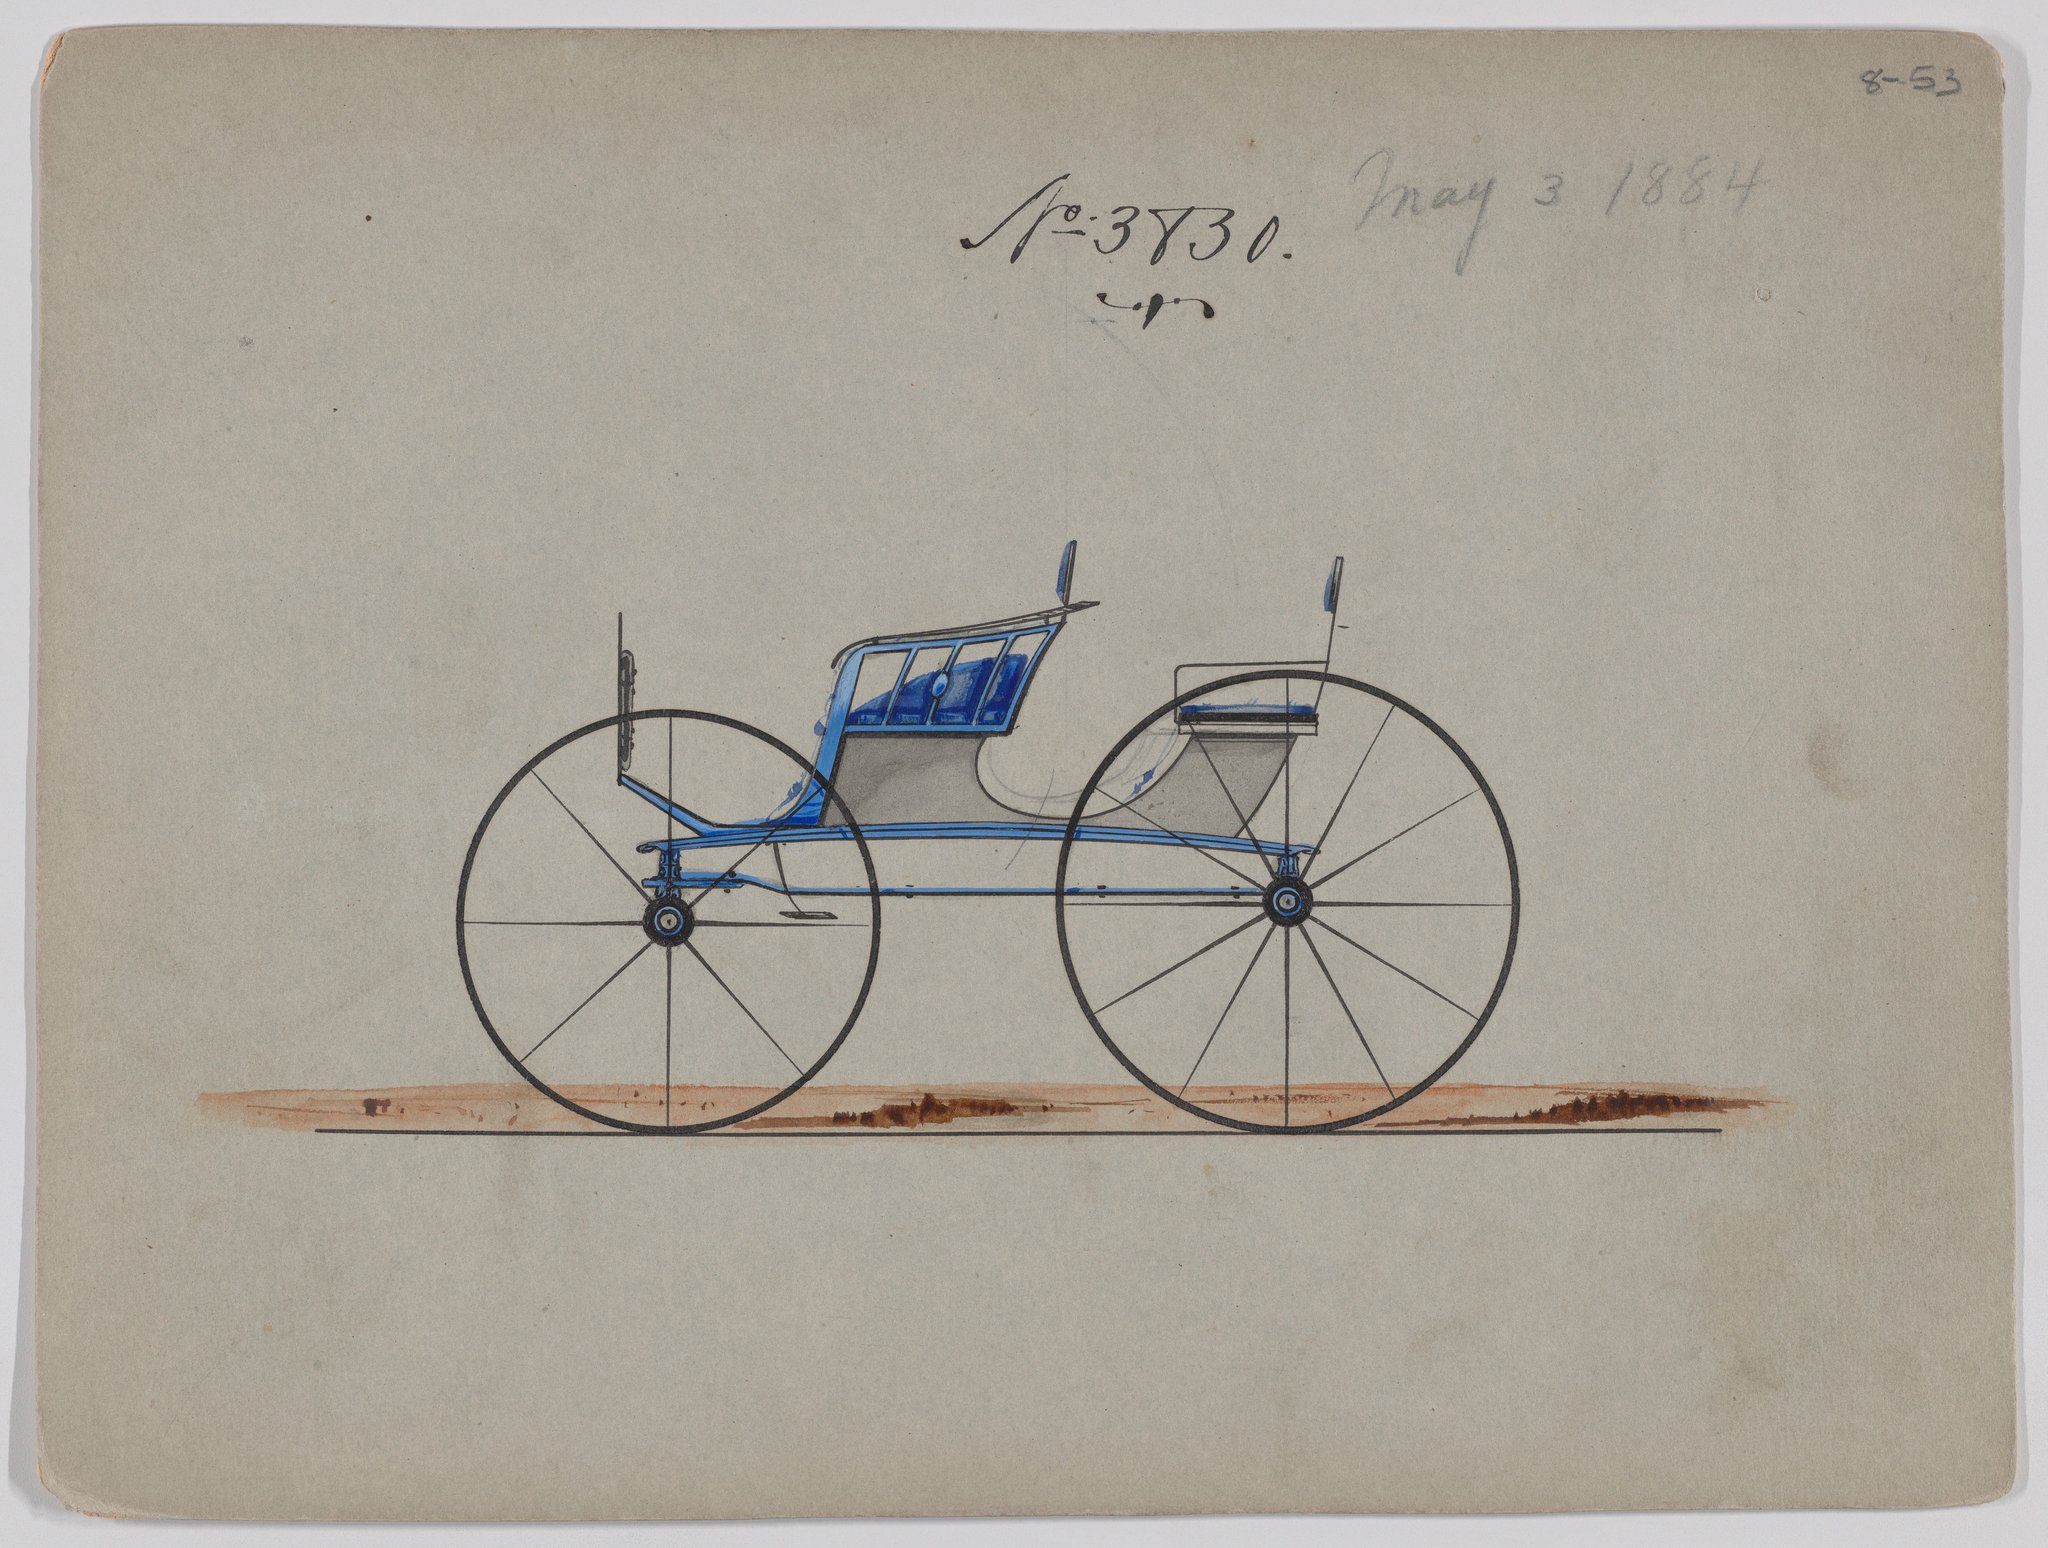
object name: drawing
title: Design for 4 seat Phaeton, no top, no. 3830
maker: brewster & co.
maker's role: manufacturer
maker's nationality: american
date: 1883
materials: gouache, gum arabic, ink, watercolor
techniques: pen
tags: carriages